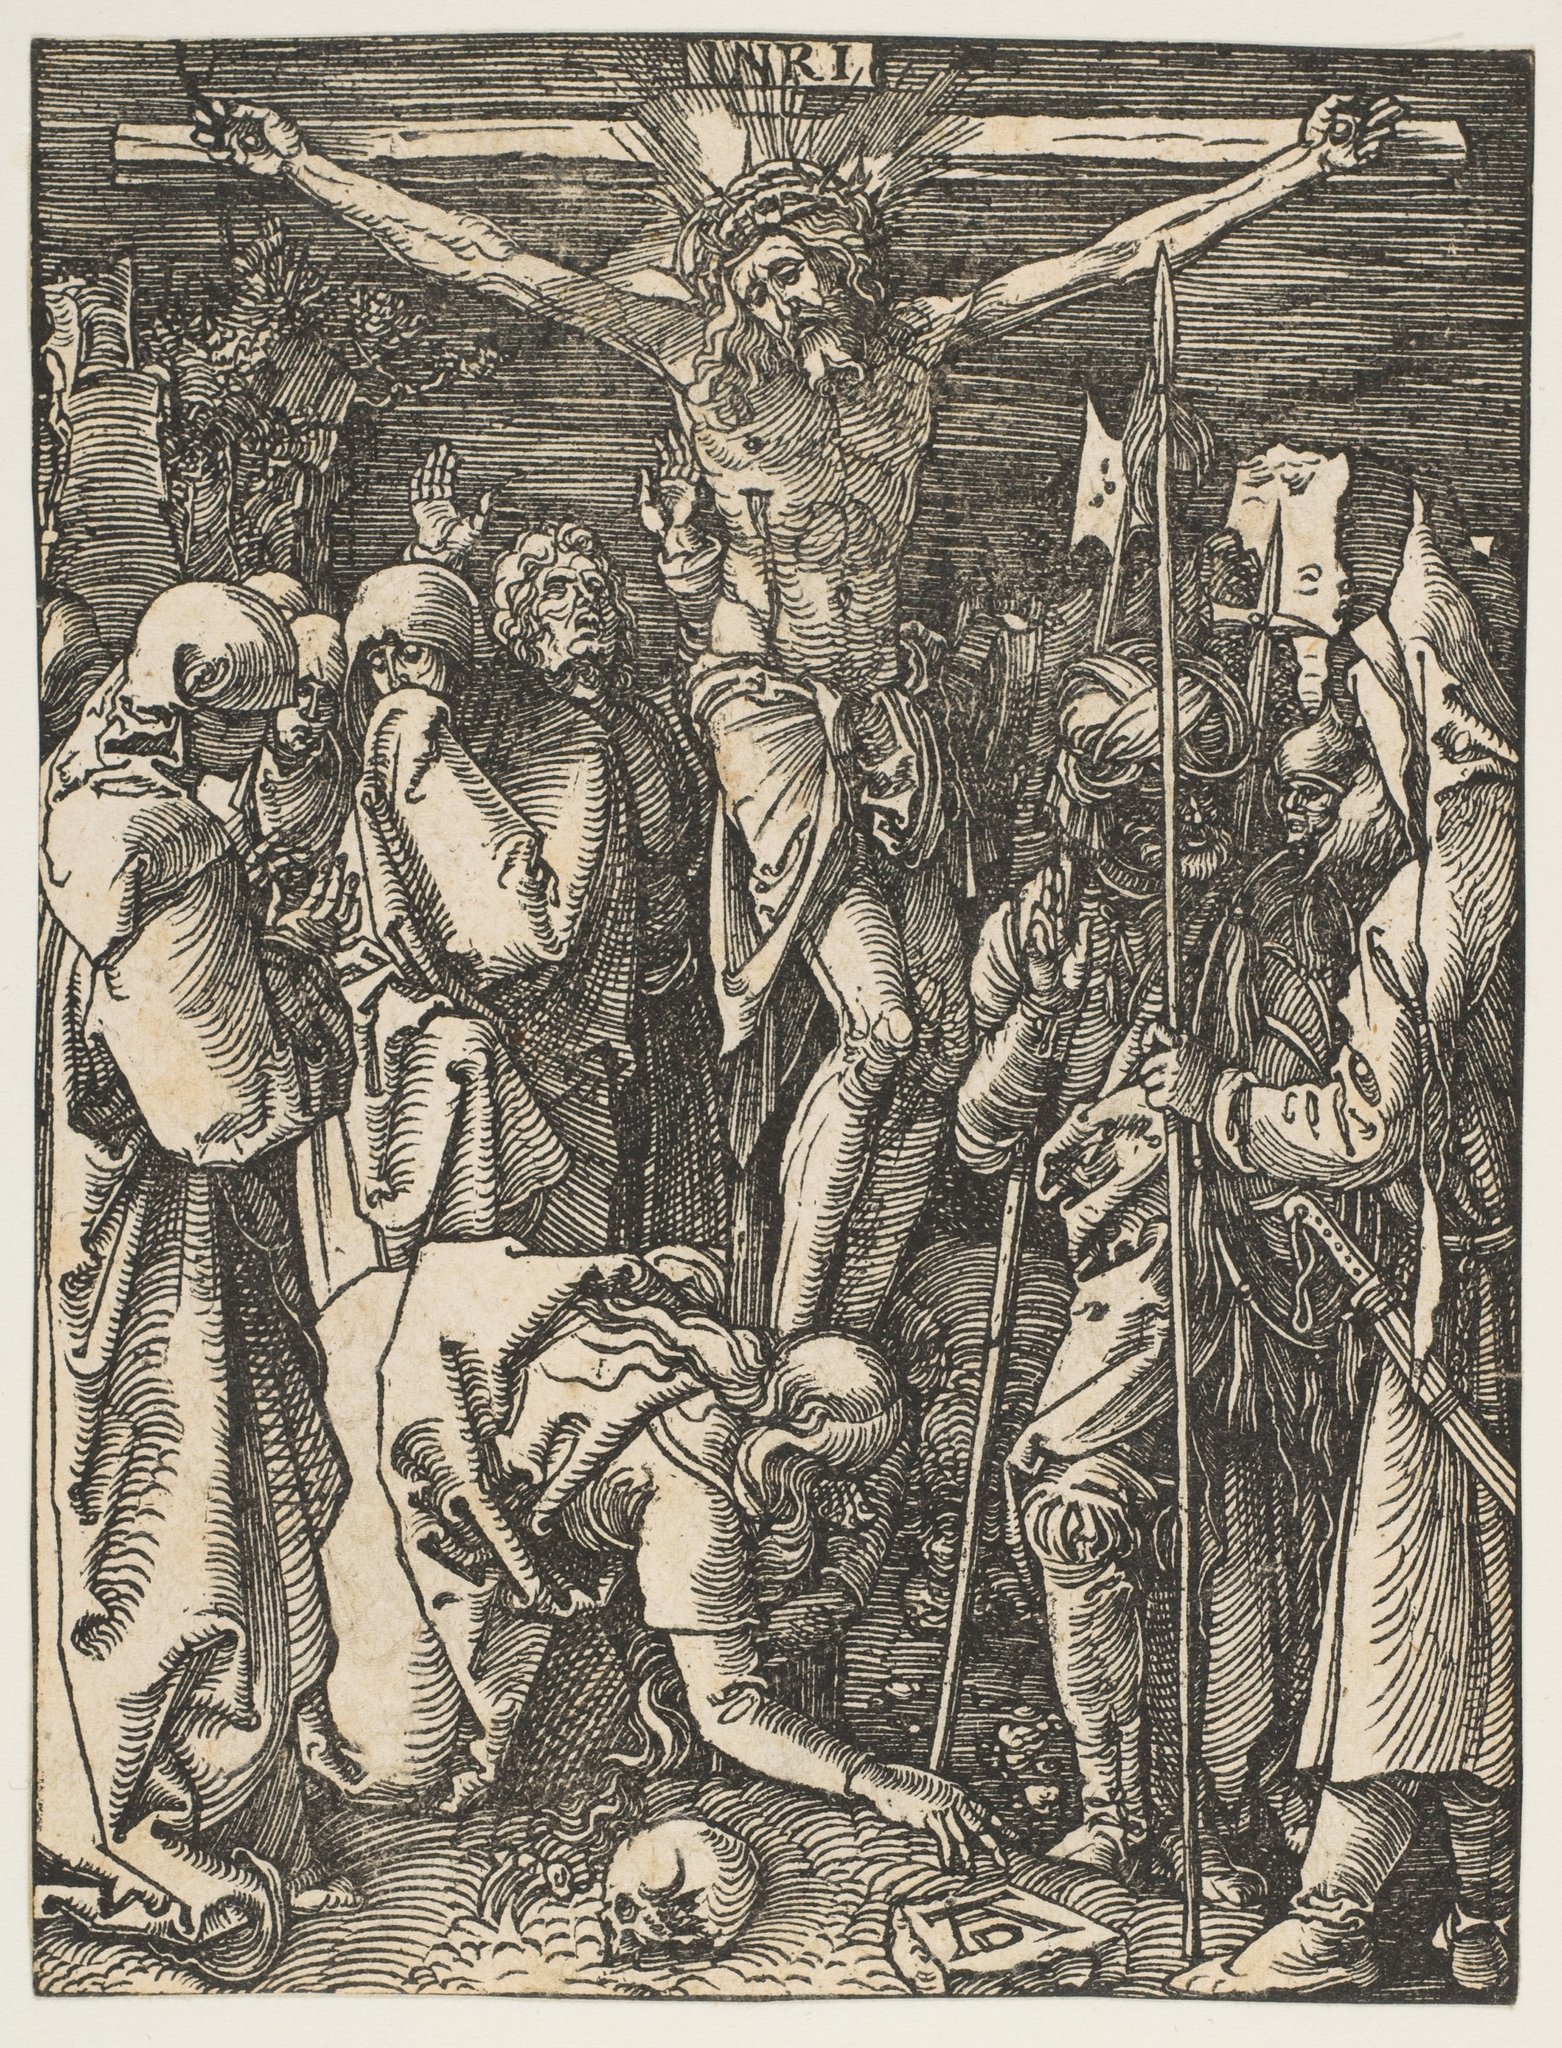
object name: print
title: The Crucifixion, from "The Small Passion"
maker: albrecht dürer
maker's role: artist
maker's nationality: german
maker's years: 1471-1528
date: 1509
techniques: woodcut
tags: men,women,christ,crucifixion